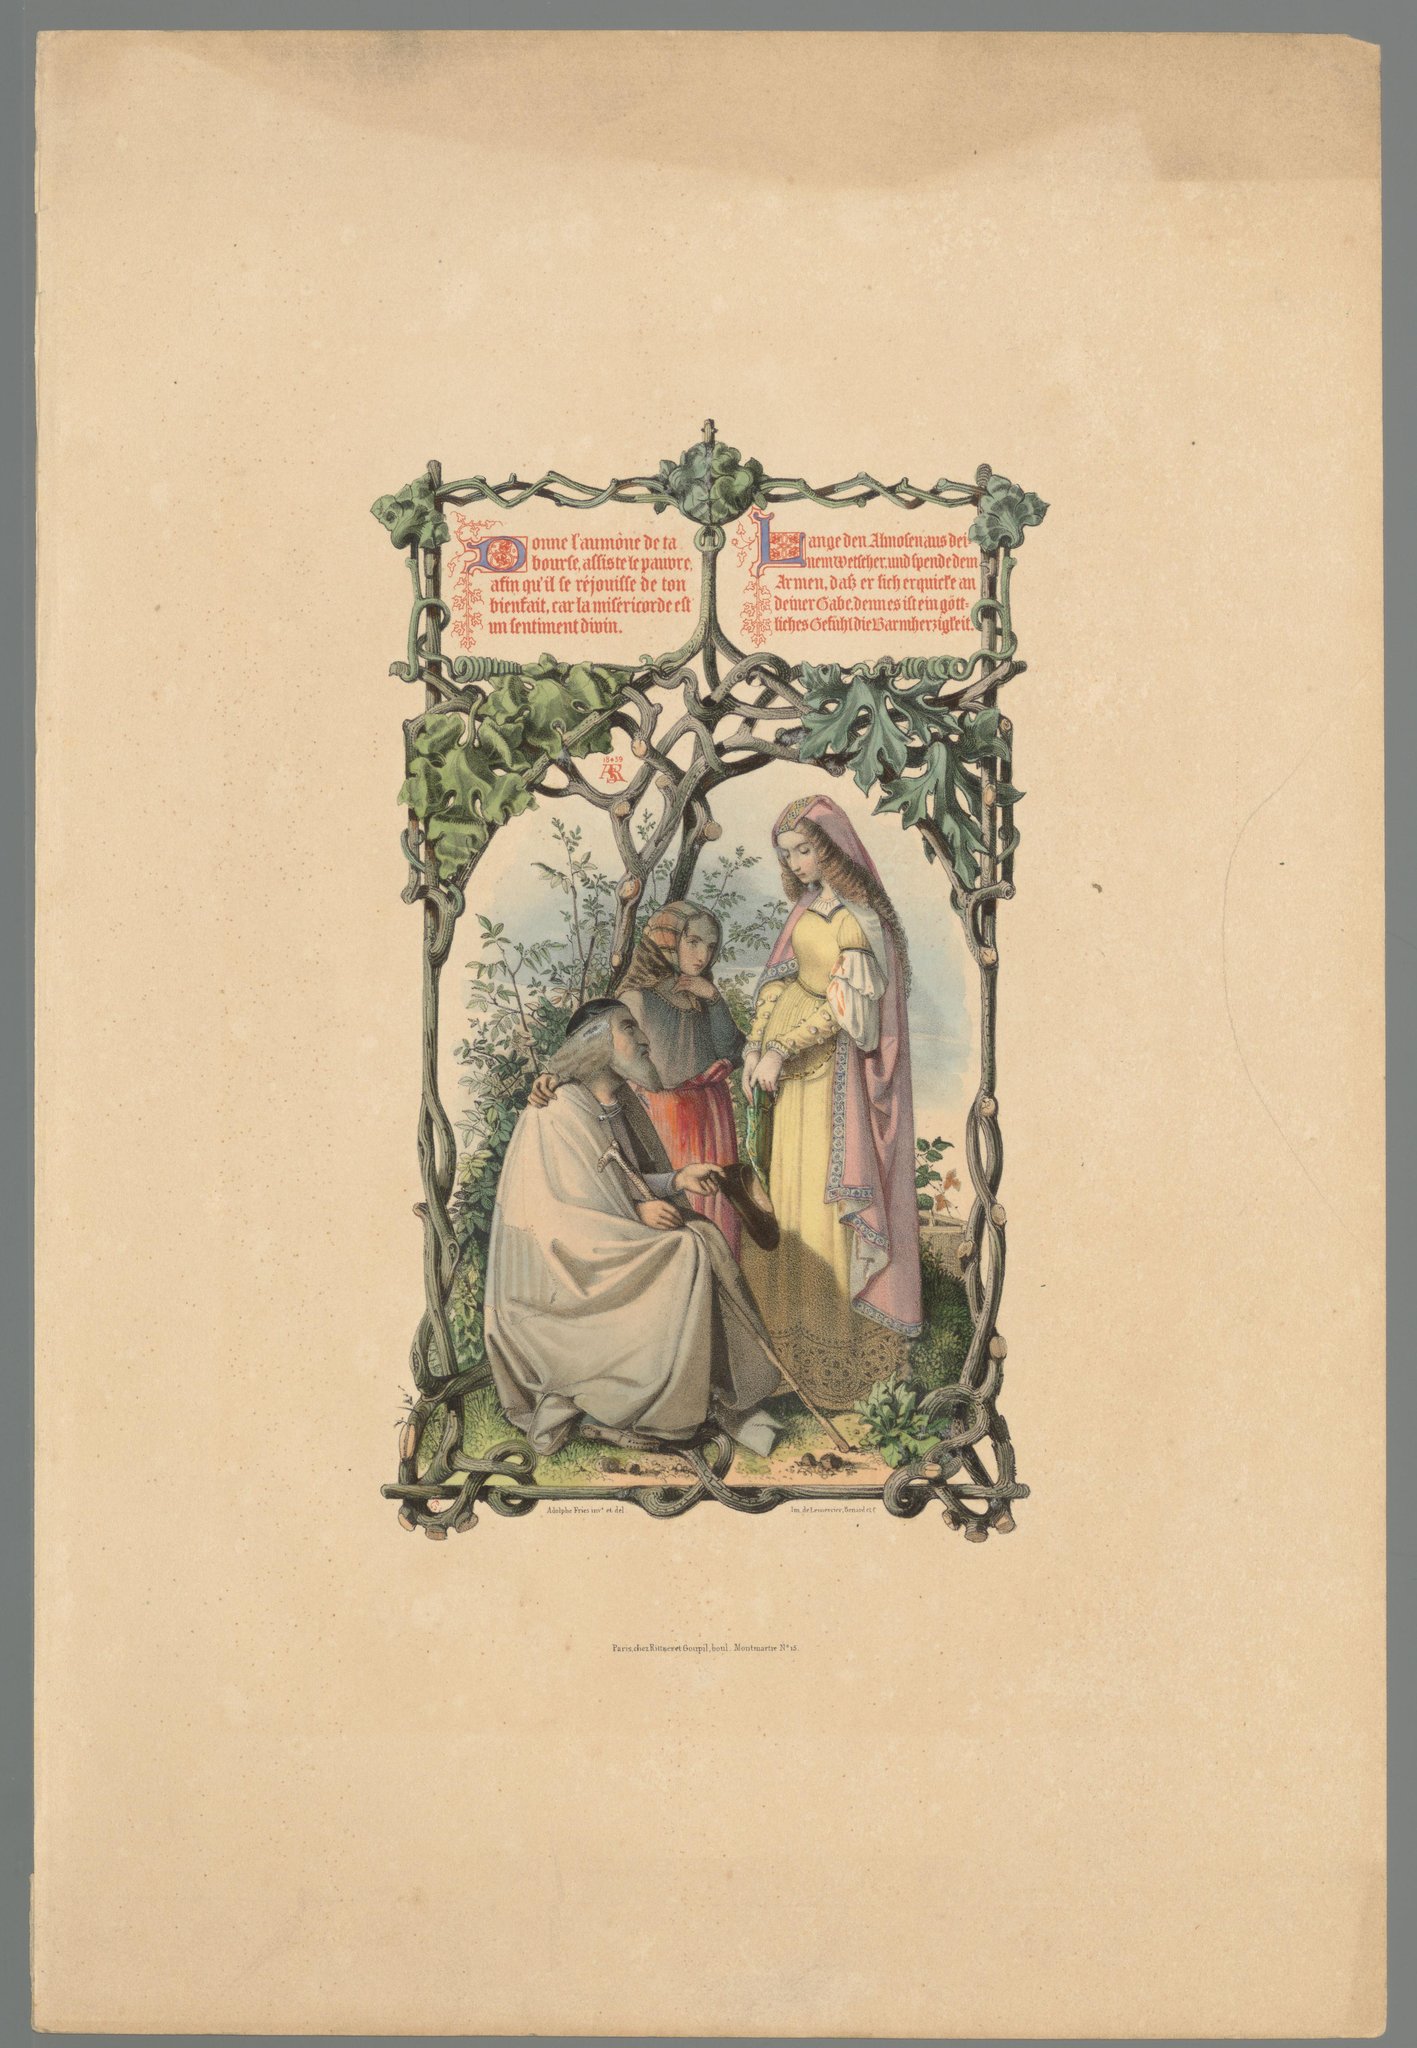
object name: print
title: Vrouw geeft aalmoes aan een man met dochter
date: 1839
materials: paper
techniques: hand coloring, lithograph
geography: paris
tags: girl (child between toddler and youth), old man, giving alms; collection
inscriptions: collector's mark: Lugt 2228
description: Prent maakt deel uit van een serie met religieuze scènes. Over deze serie is verder niets bekend. Mogelijk is het een aanvulling op de eerder uitgegeven serie 'Paroles de l'âme' van Adolf Fries in 1837.